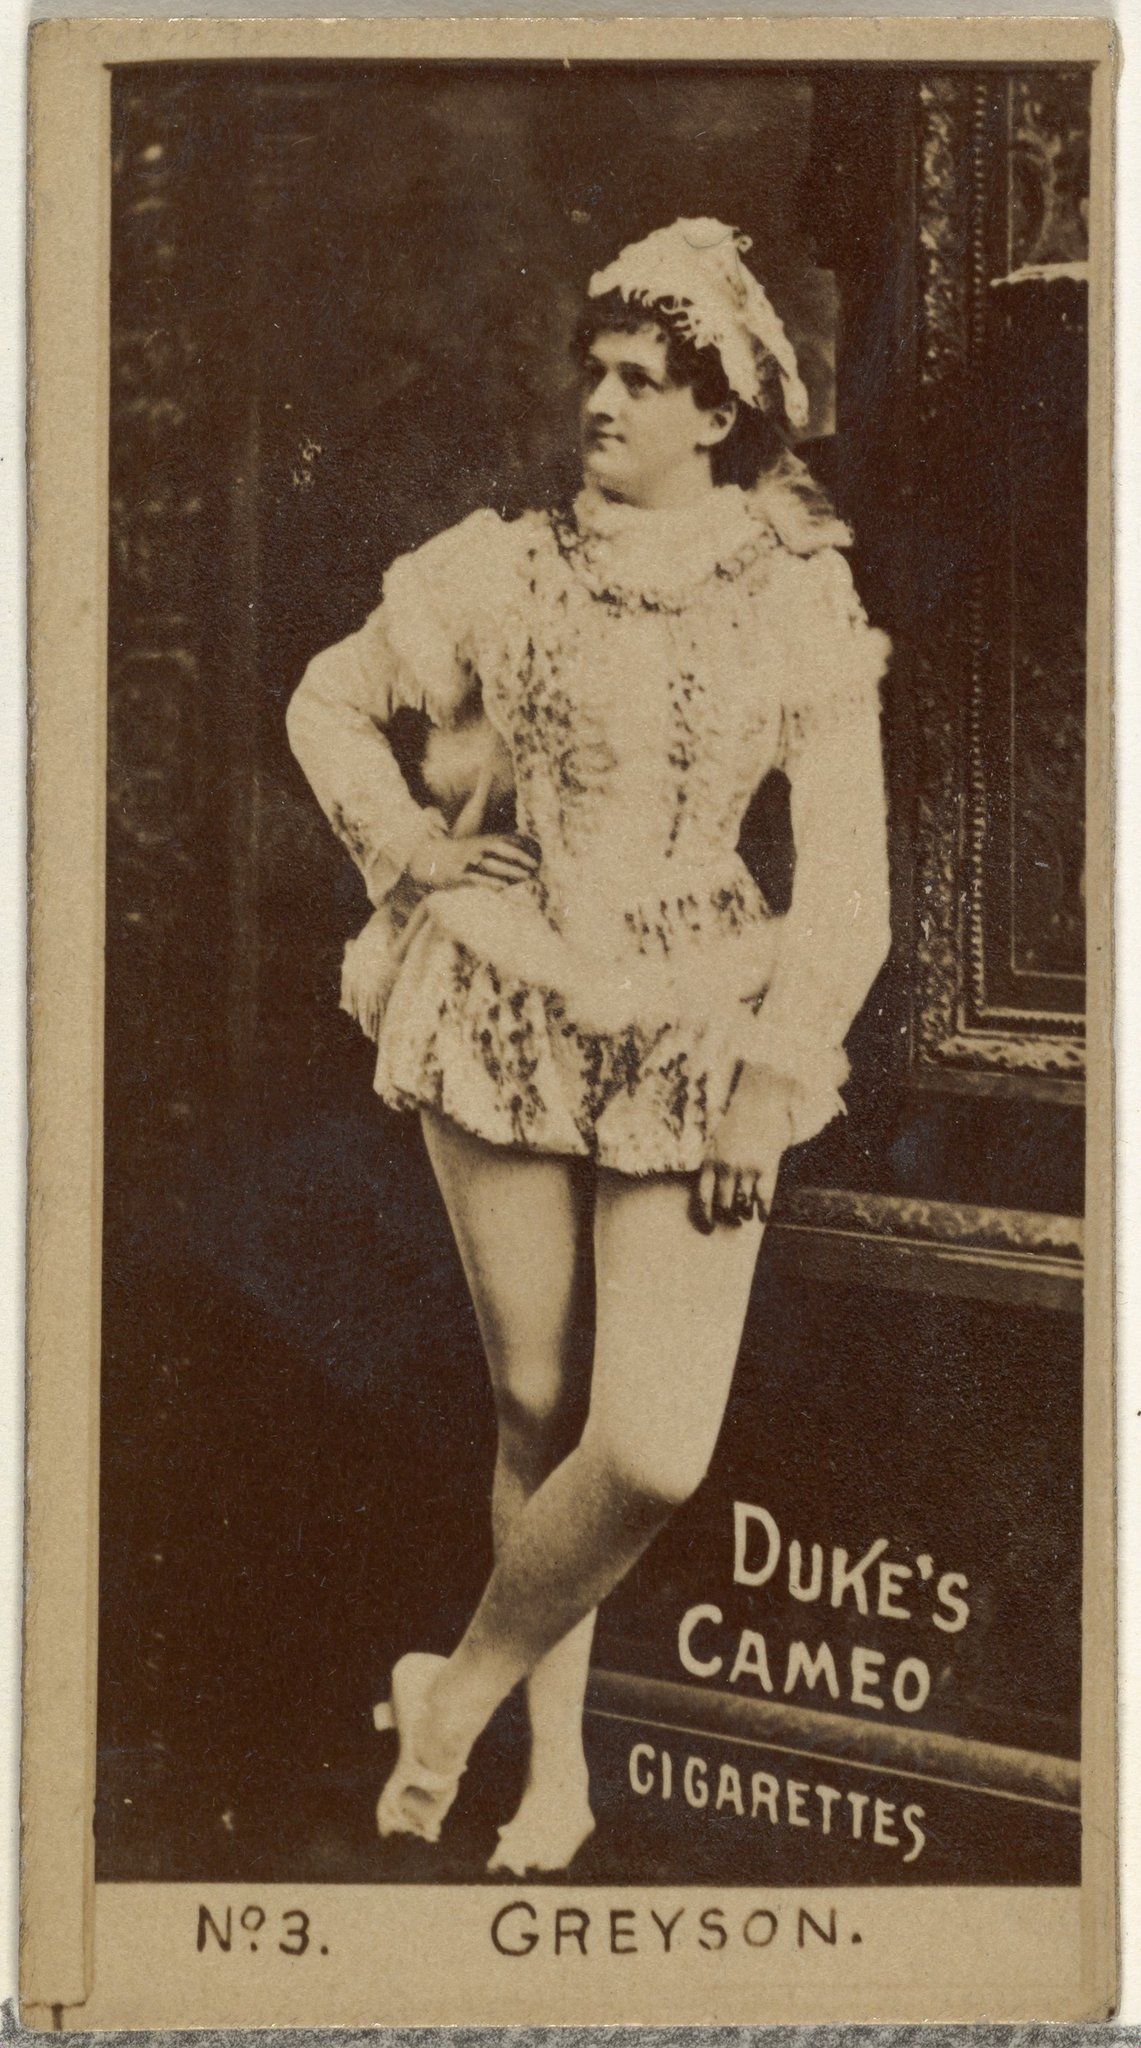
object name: photograph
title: Card Number 3, Greyson, from the Actors and Actresses series (N145-4) issued by Duke Sons & Co. to promote Cameo Cigarettes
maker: w. duke, sons & co.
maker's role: publisher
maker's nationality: american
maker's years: 1870-1920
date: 1880-1889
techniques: albumen silver print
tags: women,actresses